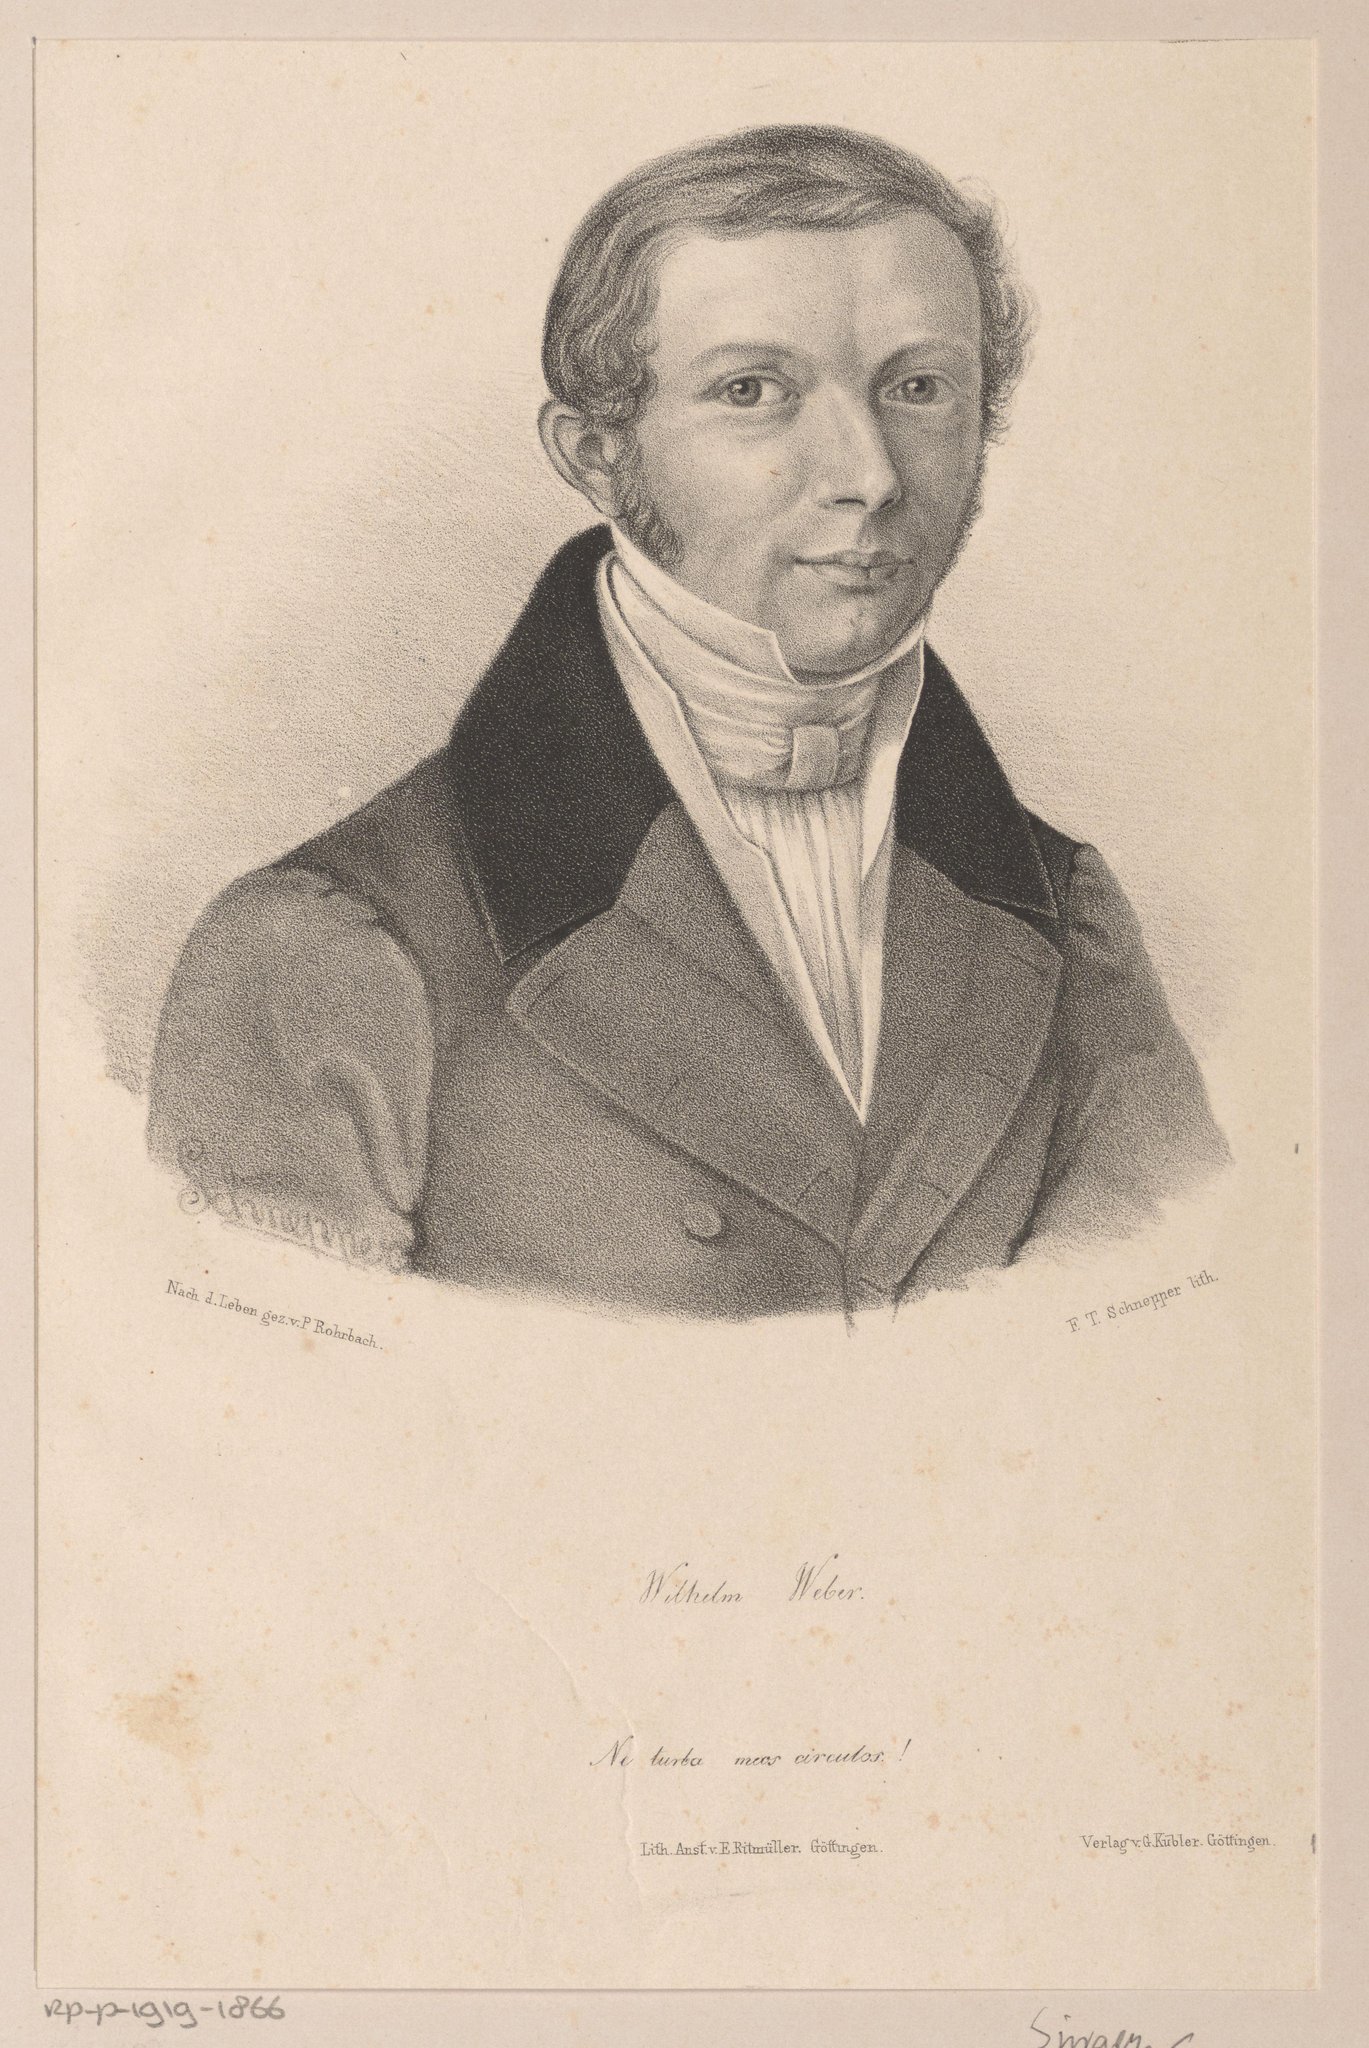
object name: print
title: Portret van Wilhelm Eduard Weber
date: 1827-1869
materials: paper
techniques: lithograph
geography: gottingen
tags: historical persons, professor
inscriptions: collector's mark: Lugt 2228